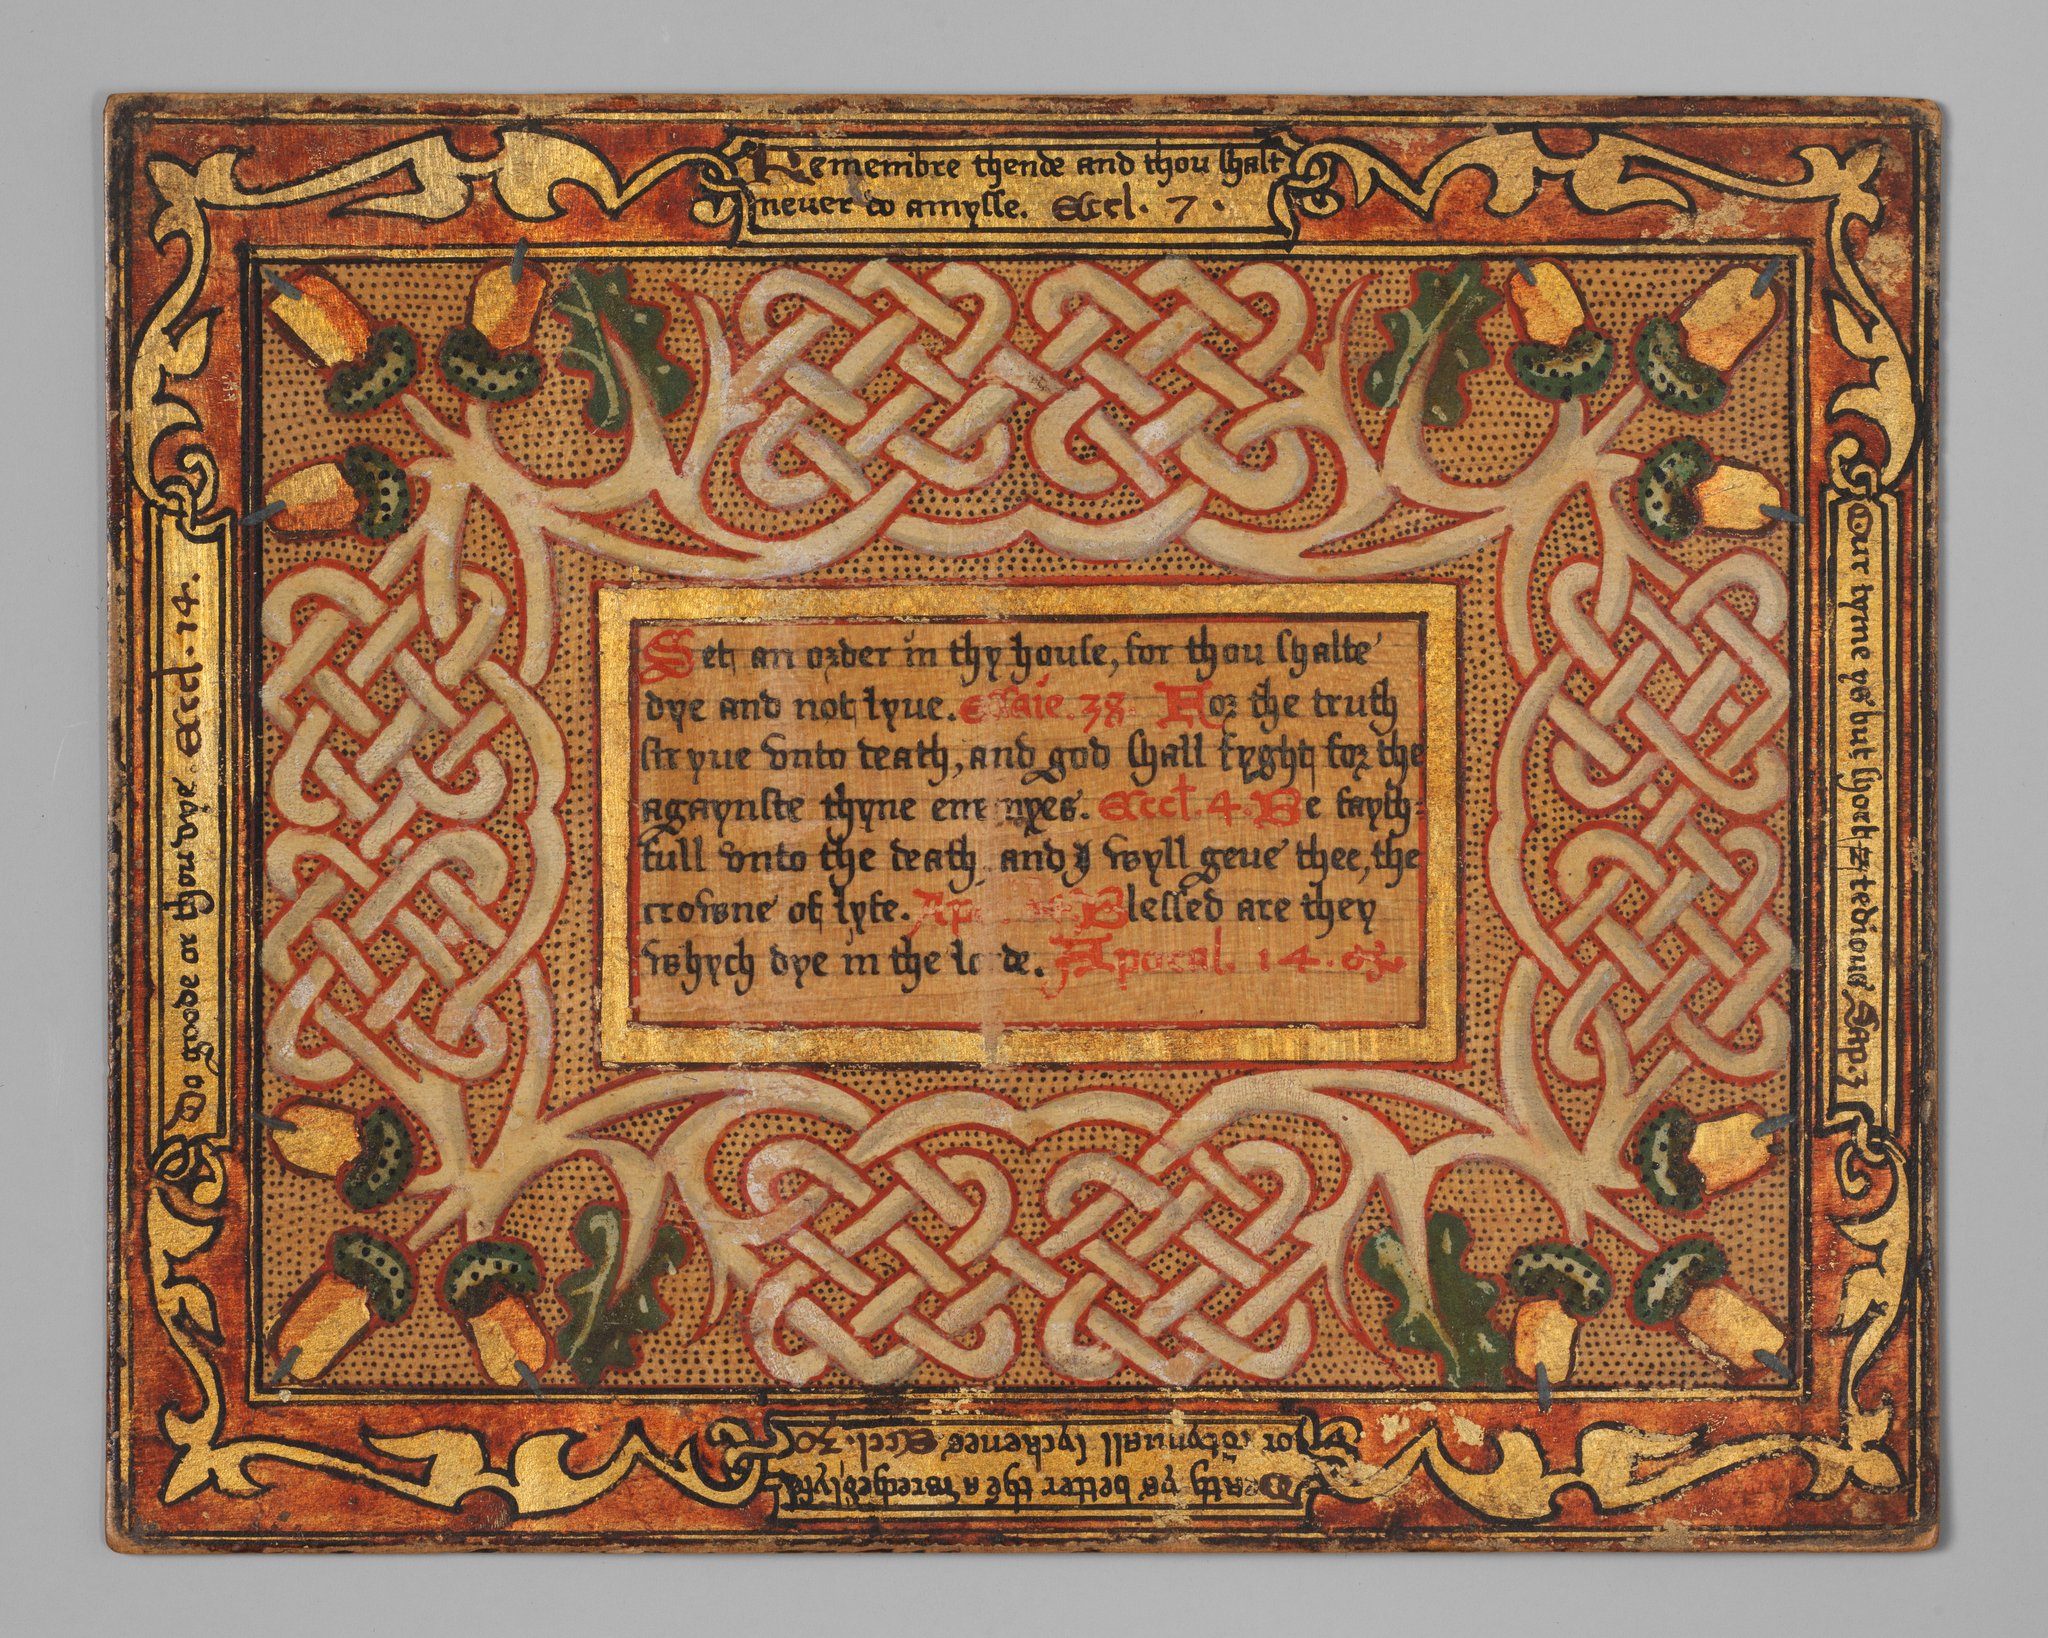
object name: trencher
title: Trencher with quotation from The Governance of Virtue (1566) (one of a set)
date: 1601-1633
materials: wood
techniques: gilding, painting